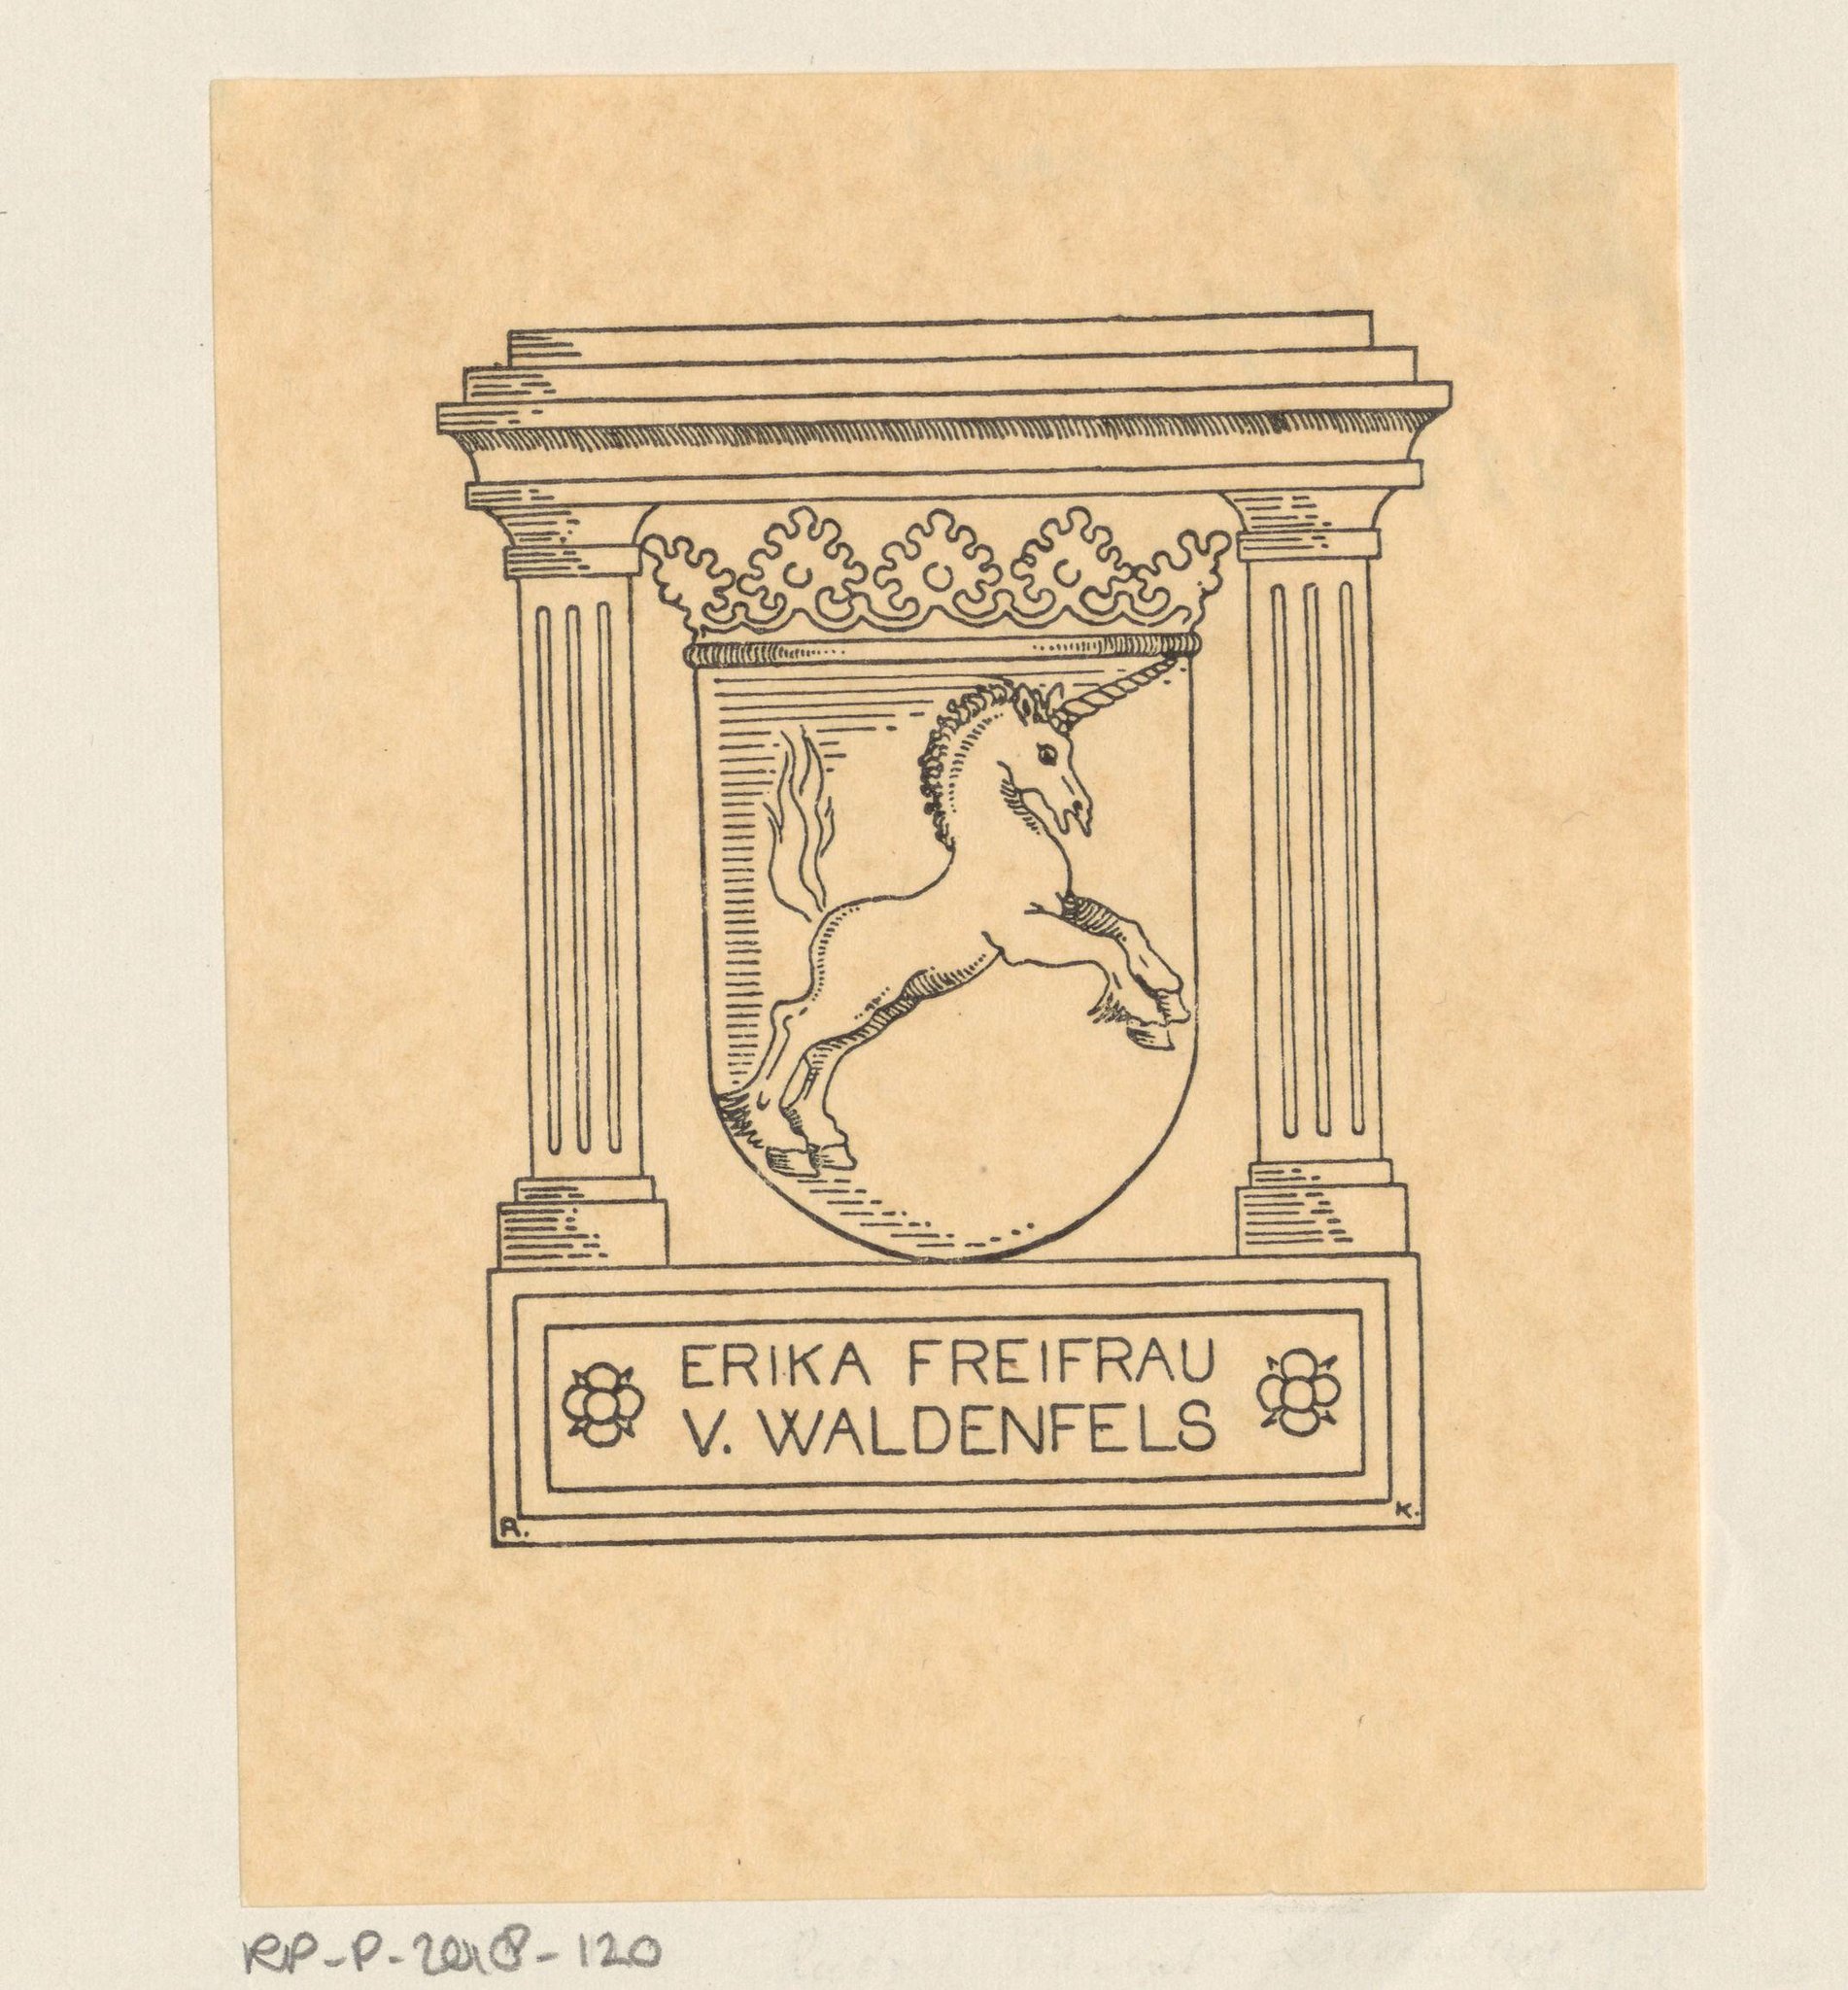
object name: bookplate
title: Ex libris van Erika barones von Waldenfels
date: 1927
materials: paper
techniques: printing block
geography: germany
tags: unicorn, column, pillar ~ architecture, armorial bearing, heraldry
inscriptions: inscription: ‘Rudolf Klement Kornenburg/ 1927’